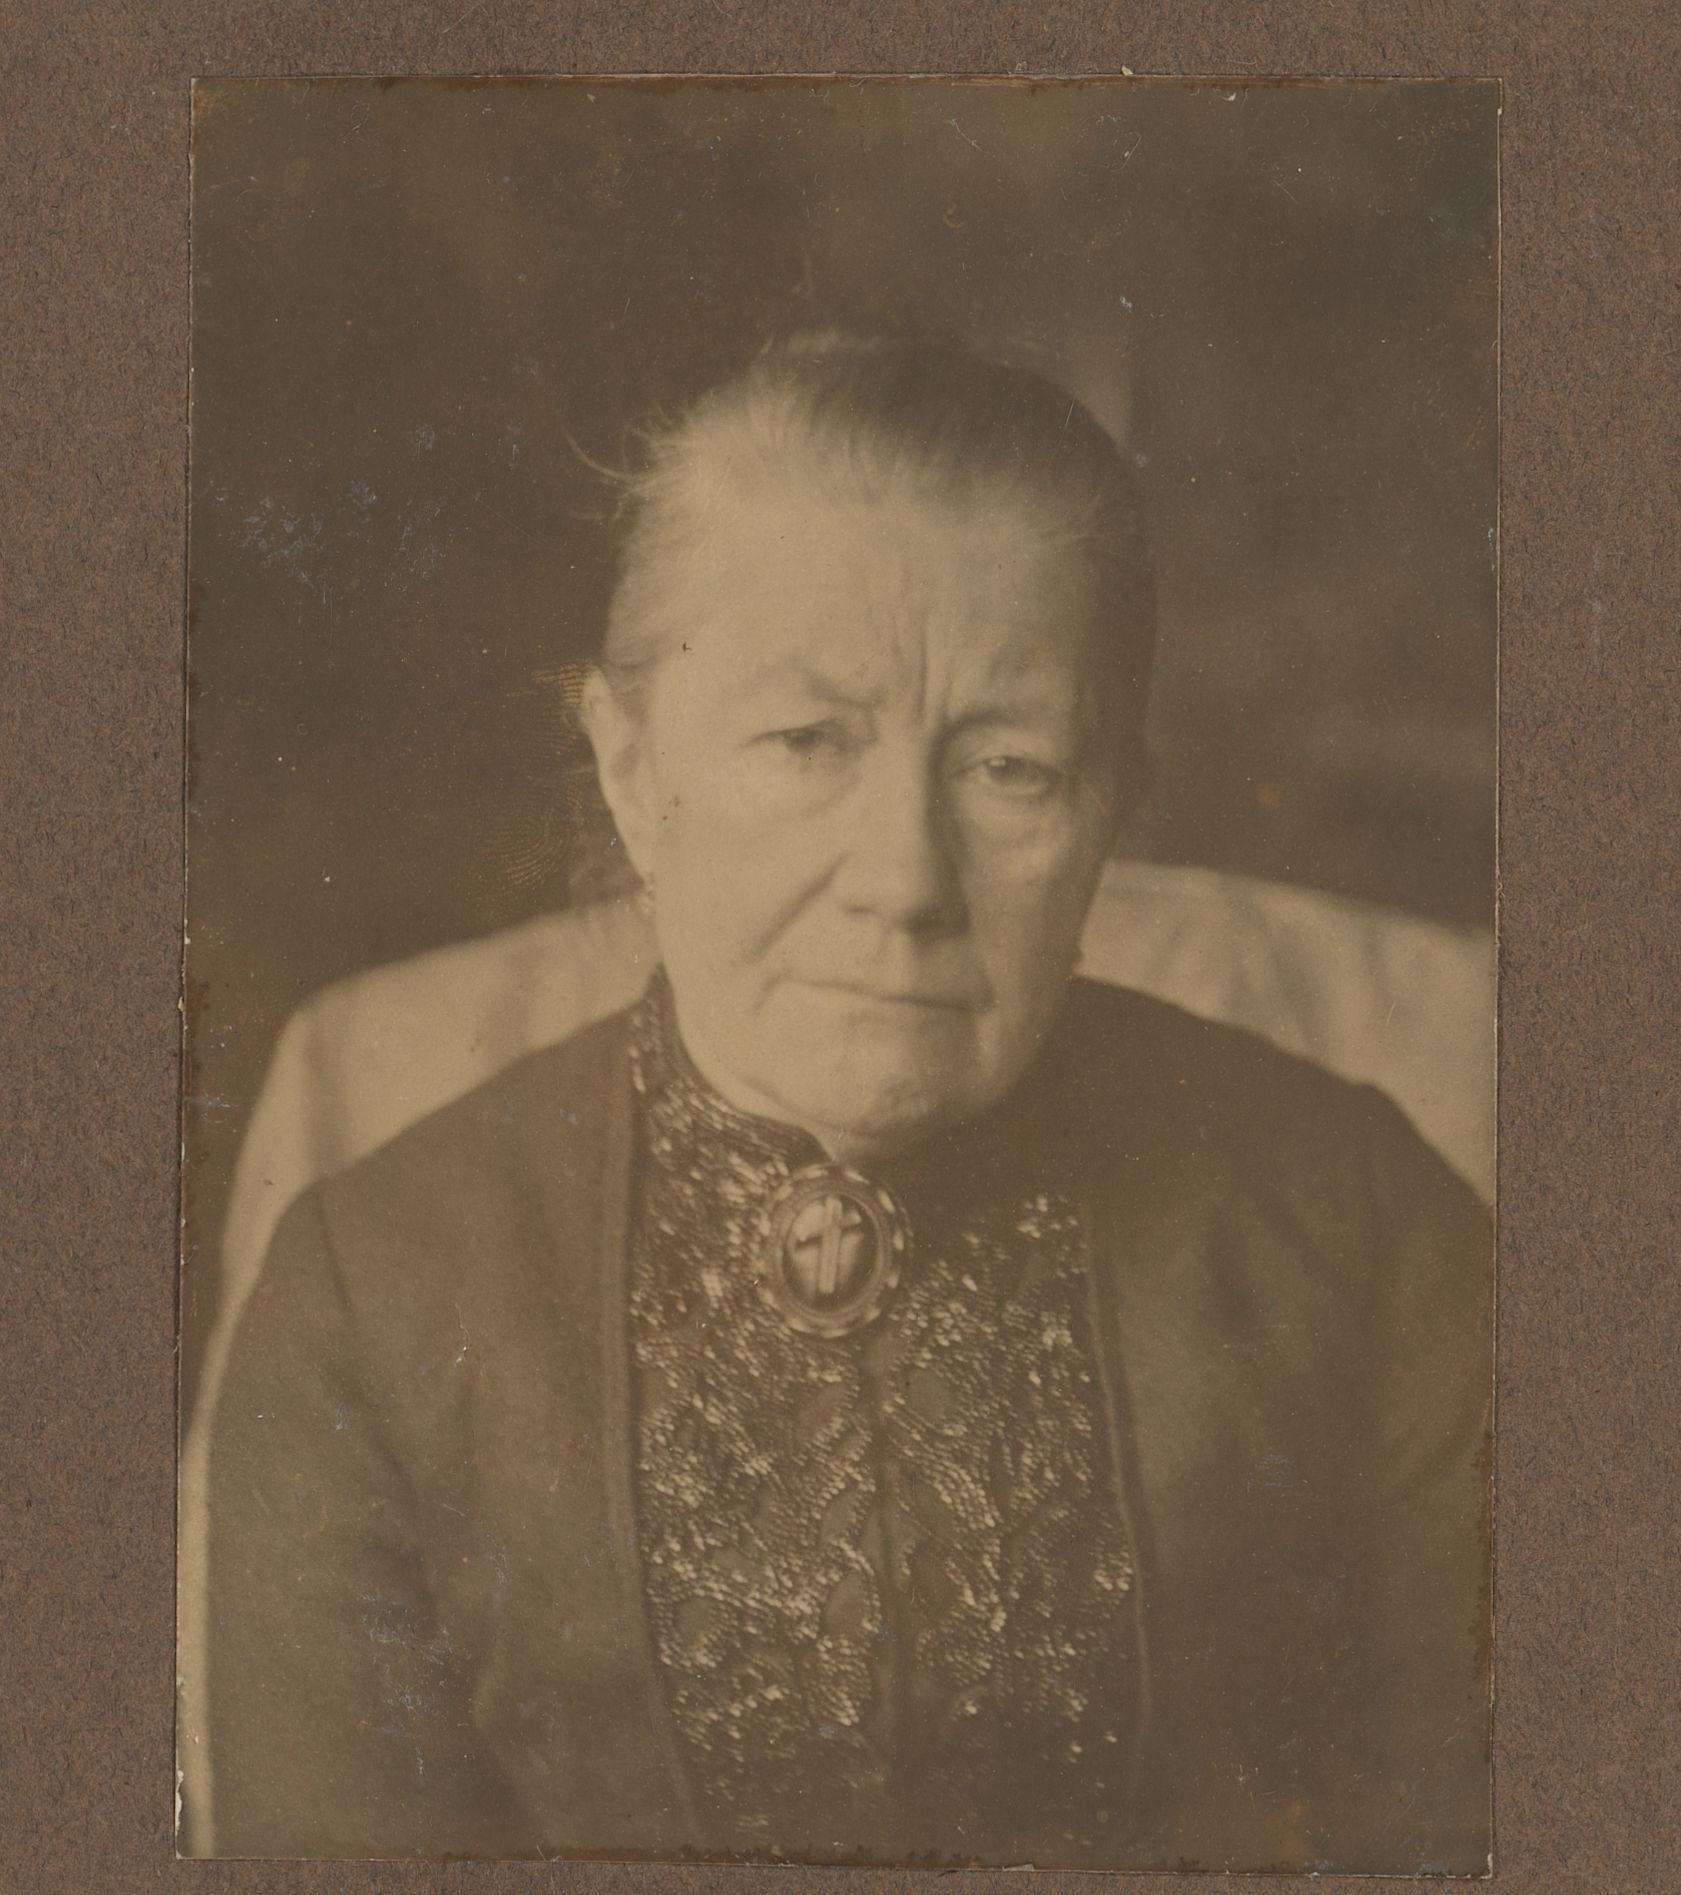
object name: photograph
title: Portret van vrouw met rouwbroche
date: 1870-1920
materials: photographic support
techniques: photography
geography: netherlands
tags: netherlands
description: Foto op bruin albumblad 31 van familiealbum van Alphons Diepenbrock.